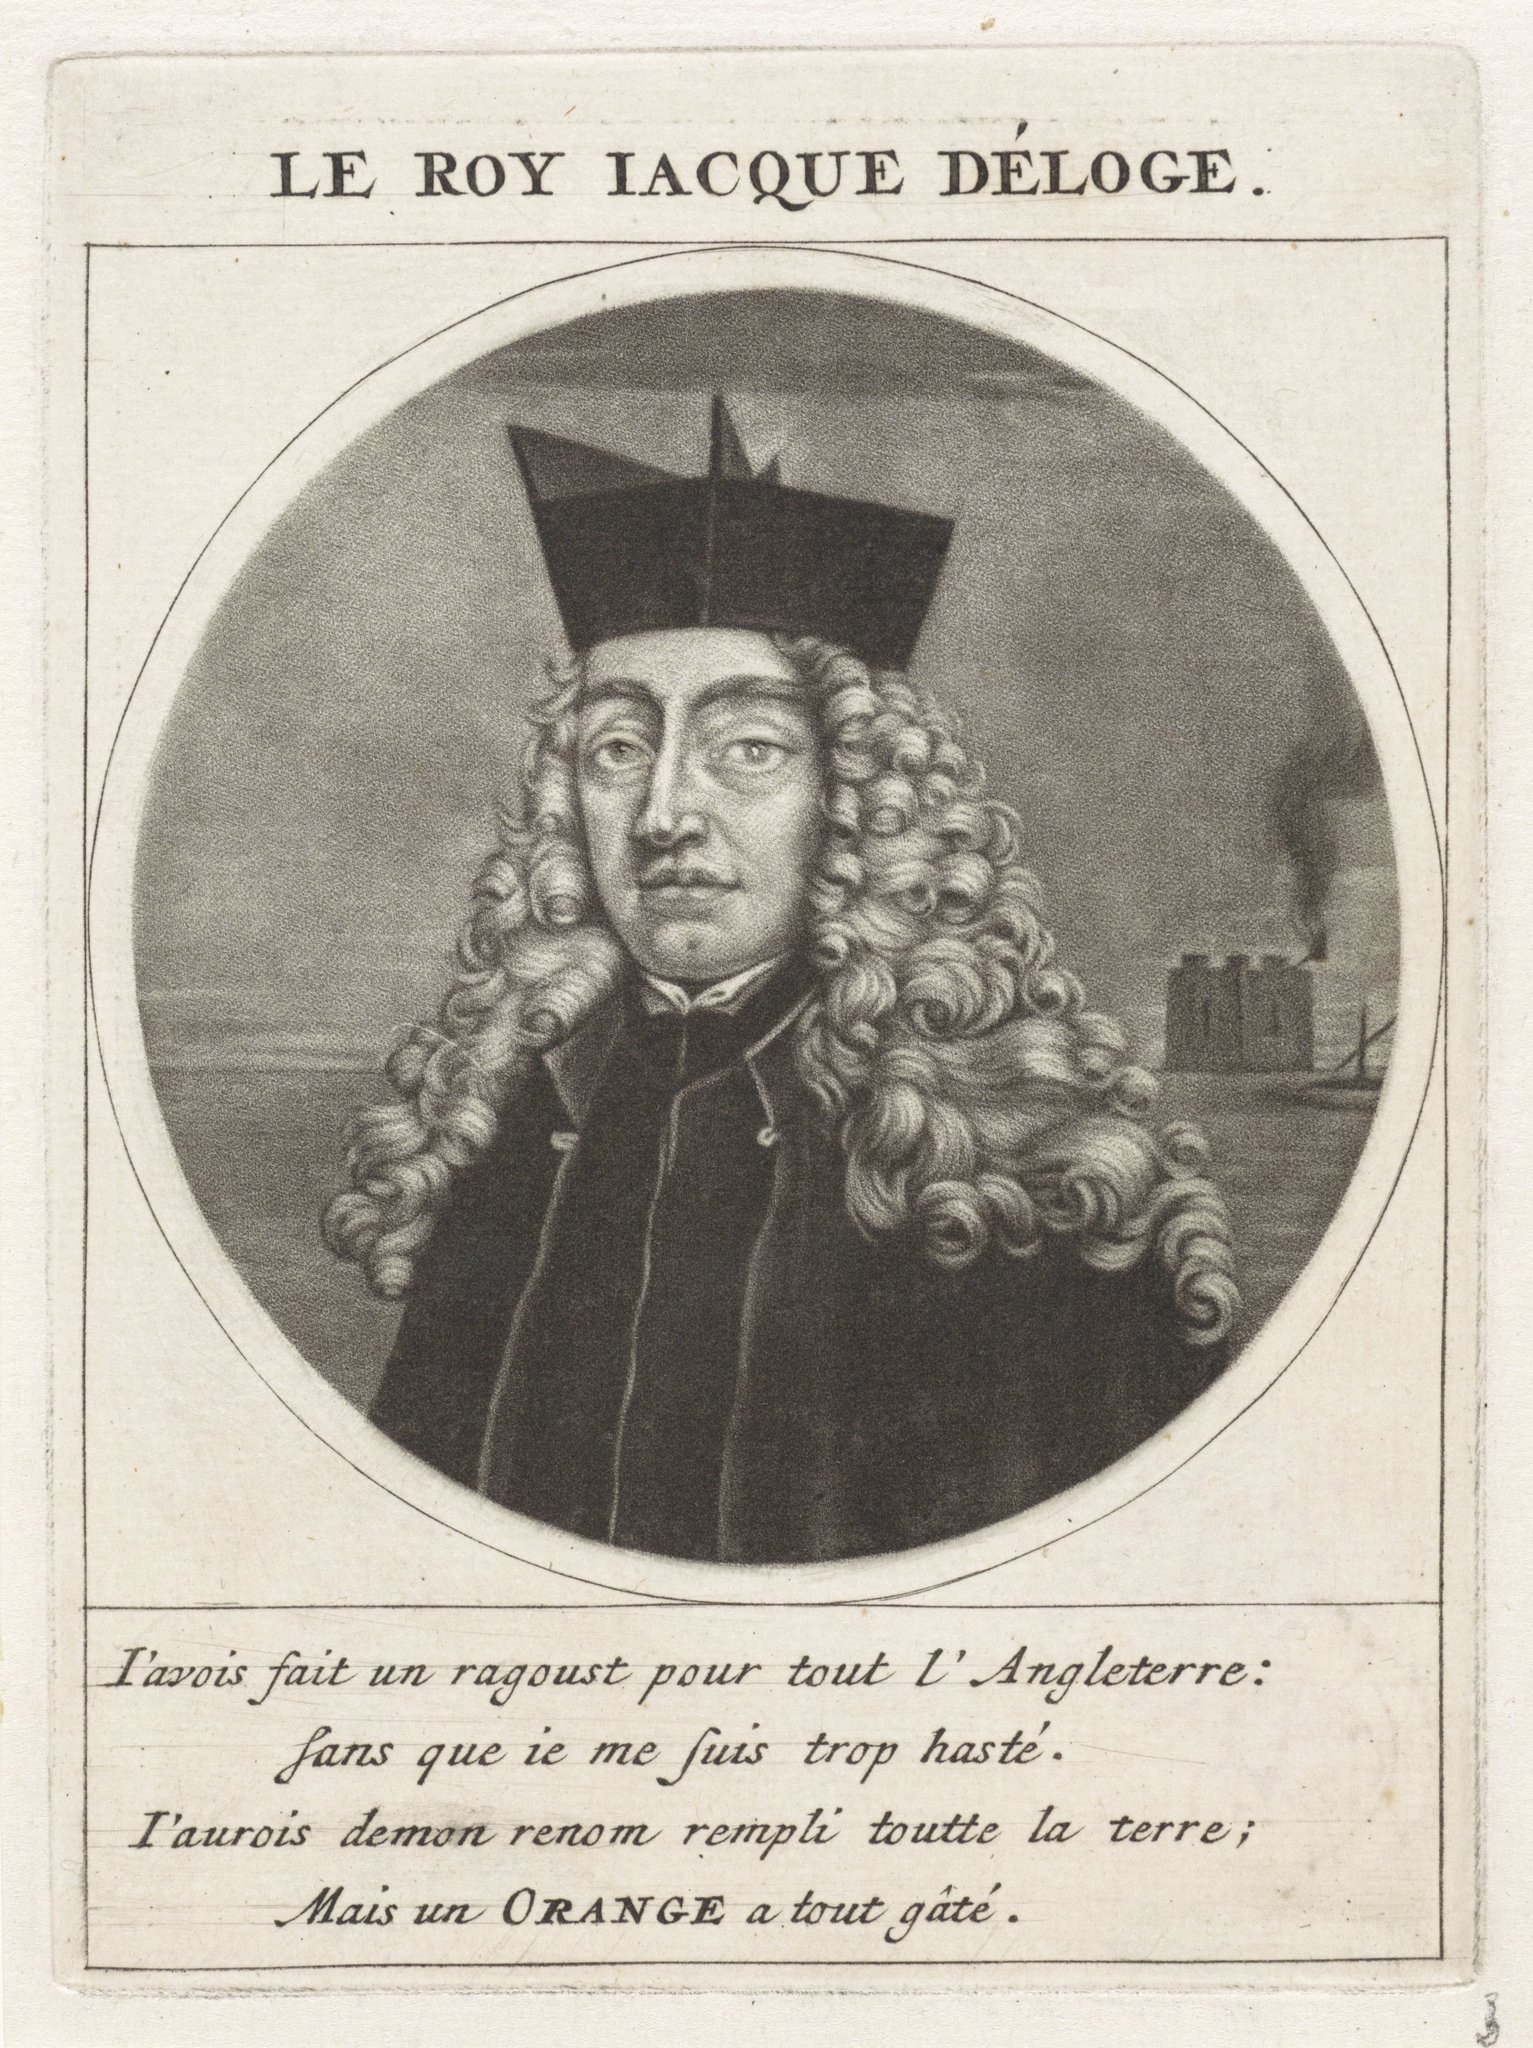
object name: print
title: Les Héros de la Ligue ou La Procession Monacale, conduitte par Louis XIV pour la Conversion des Protestans de son Royaume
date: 1691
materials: paper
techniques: engraving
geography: paris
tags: jacobus ii (koning van engeland en schotland), wig, political caricatures and satires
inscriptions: collector's mark: Lugt 240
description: Titelpagina voor: Les Heros de la Ligue: ou la procession monacale, conduitte par Louis XIV, pour la conversion des Protestants de son royaume. Chez. Pere Peters en Louis le Grand: Parijs, 1691. (De uitgevers zijn fictief.)